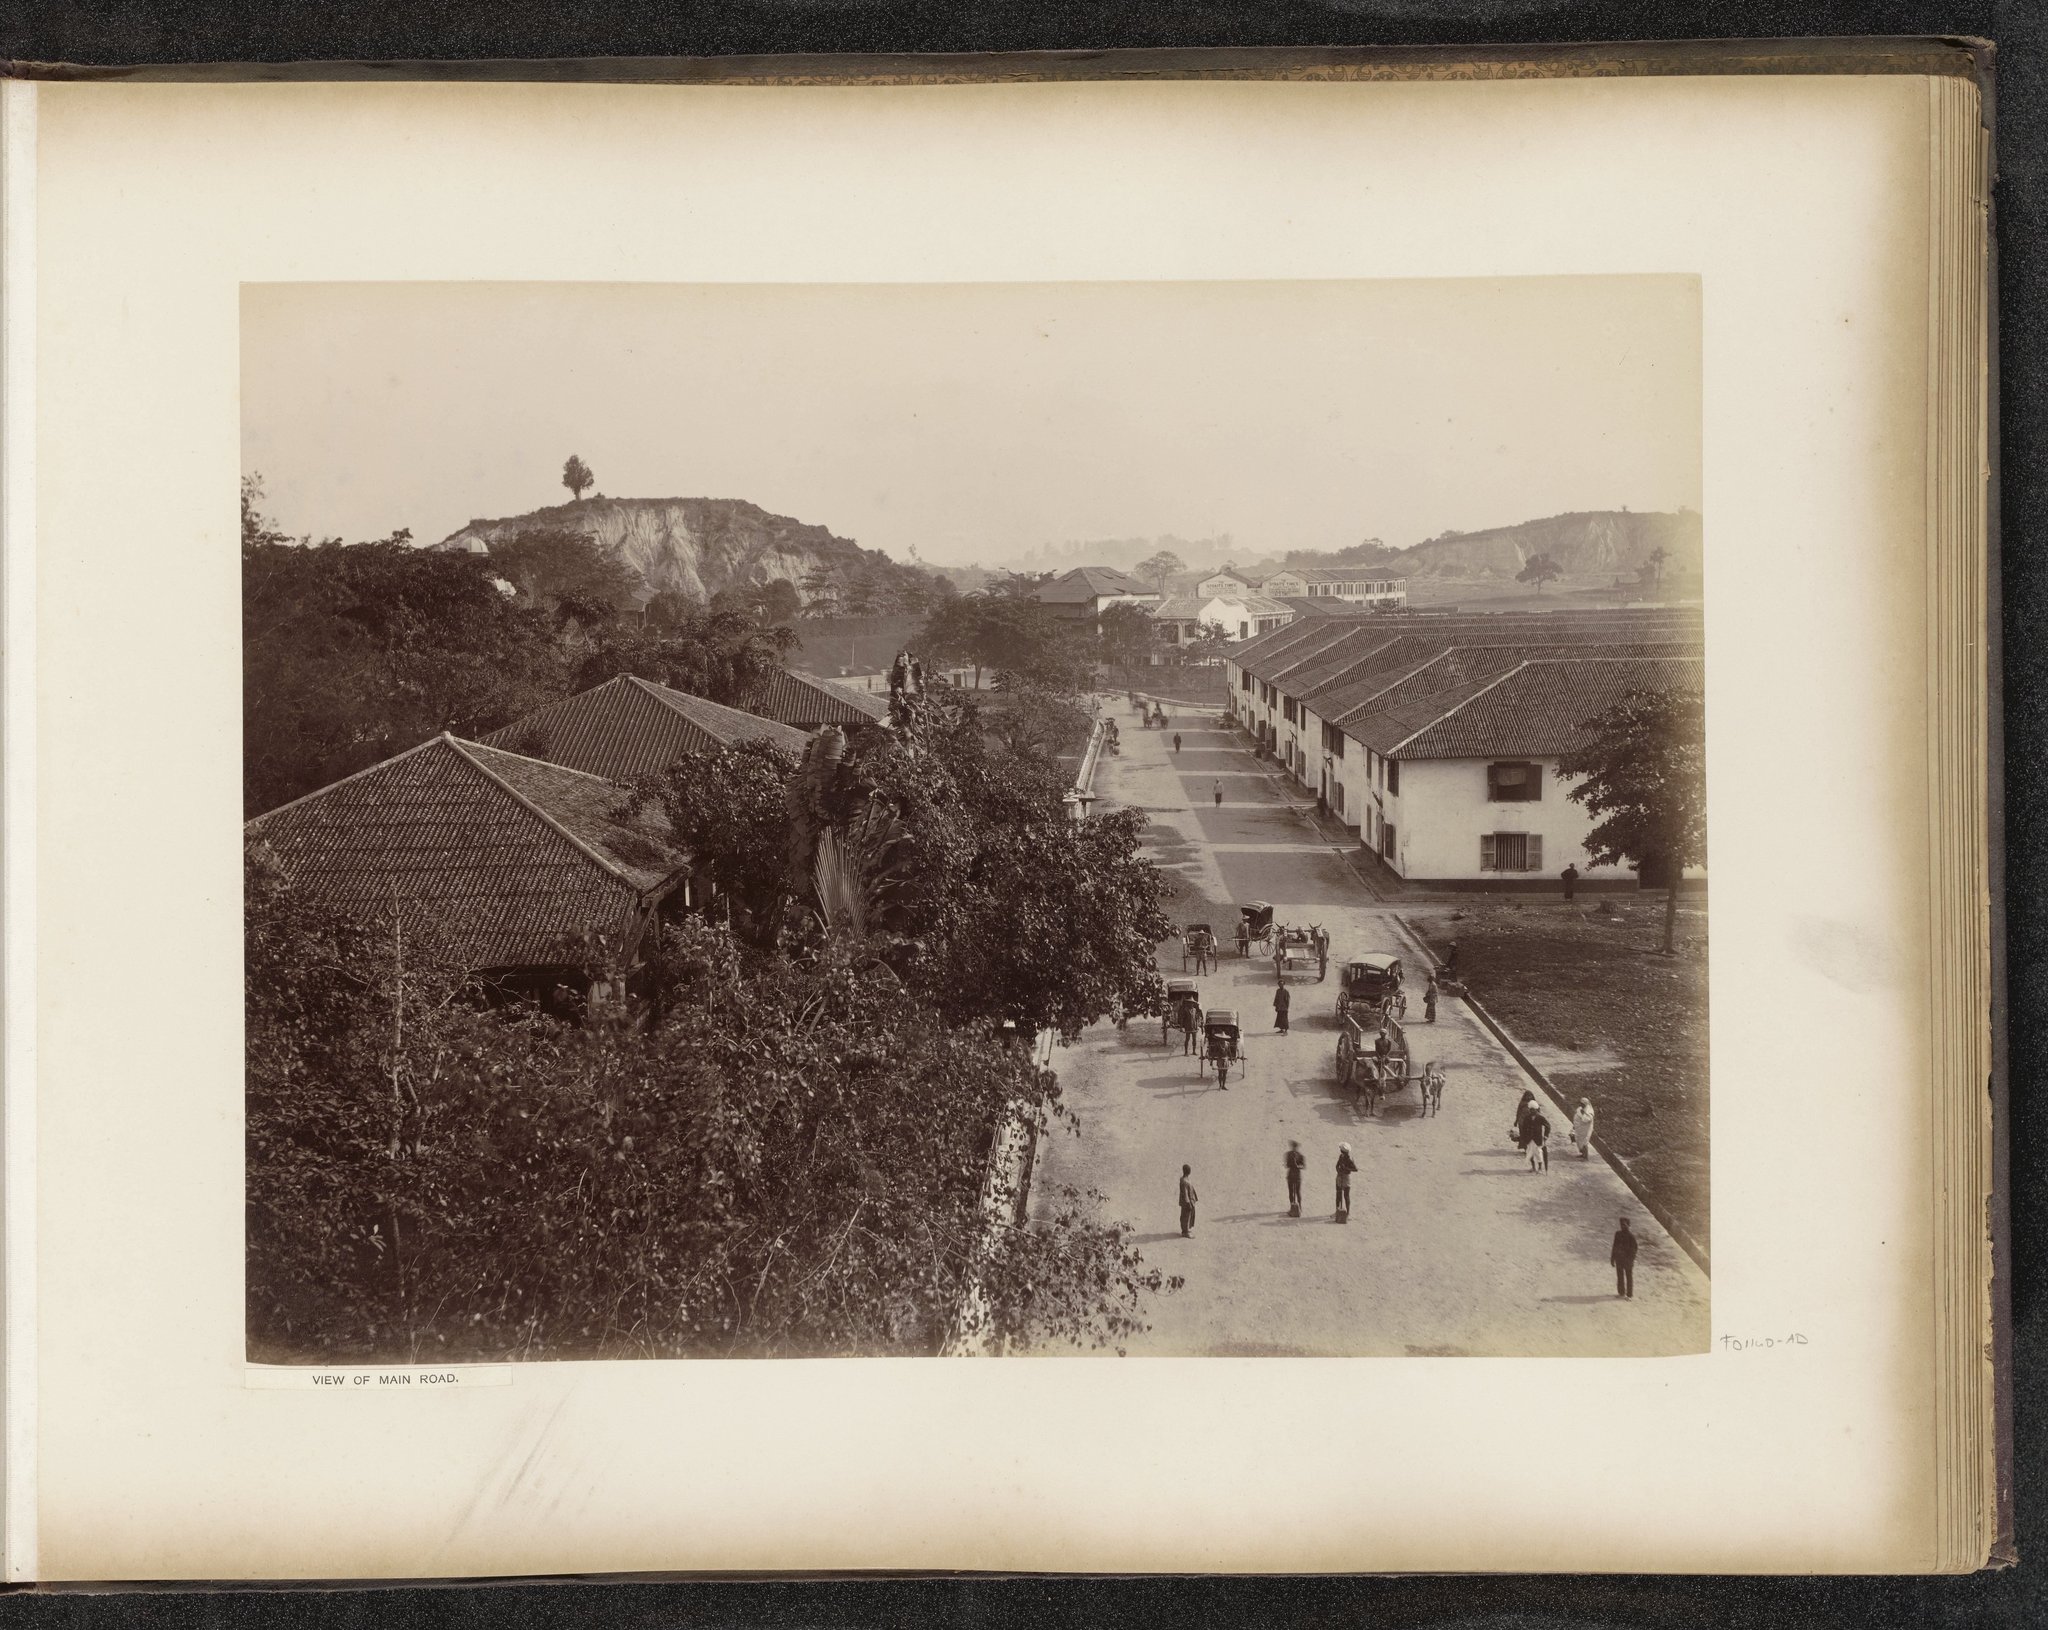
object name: photograph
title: Hoofdweg van Tanjong Pagar in Singapore met voorbijgangers, karren en reclameborden voor de krant 'The Straits Times'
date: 1890-1905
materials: photographic support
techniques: albumen print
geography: singapore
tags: advertising, public road, singapore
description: Onderdeel van Fotoalbum van de Tanjong Pagar Dock Co. Ltd. in Singapore.